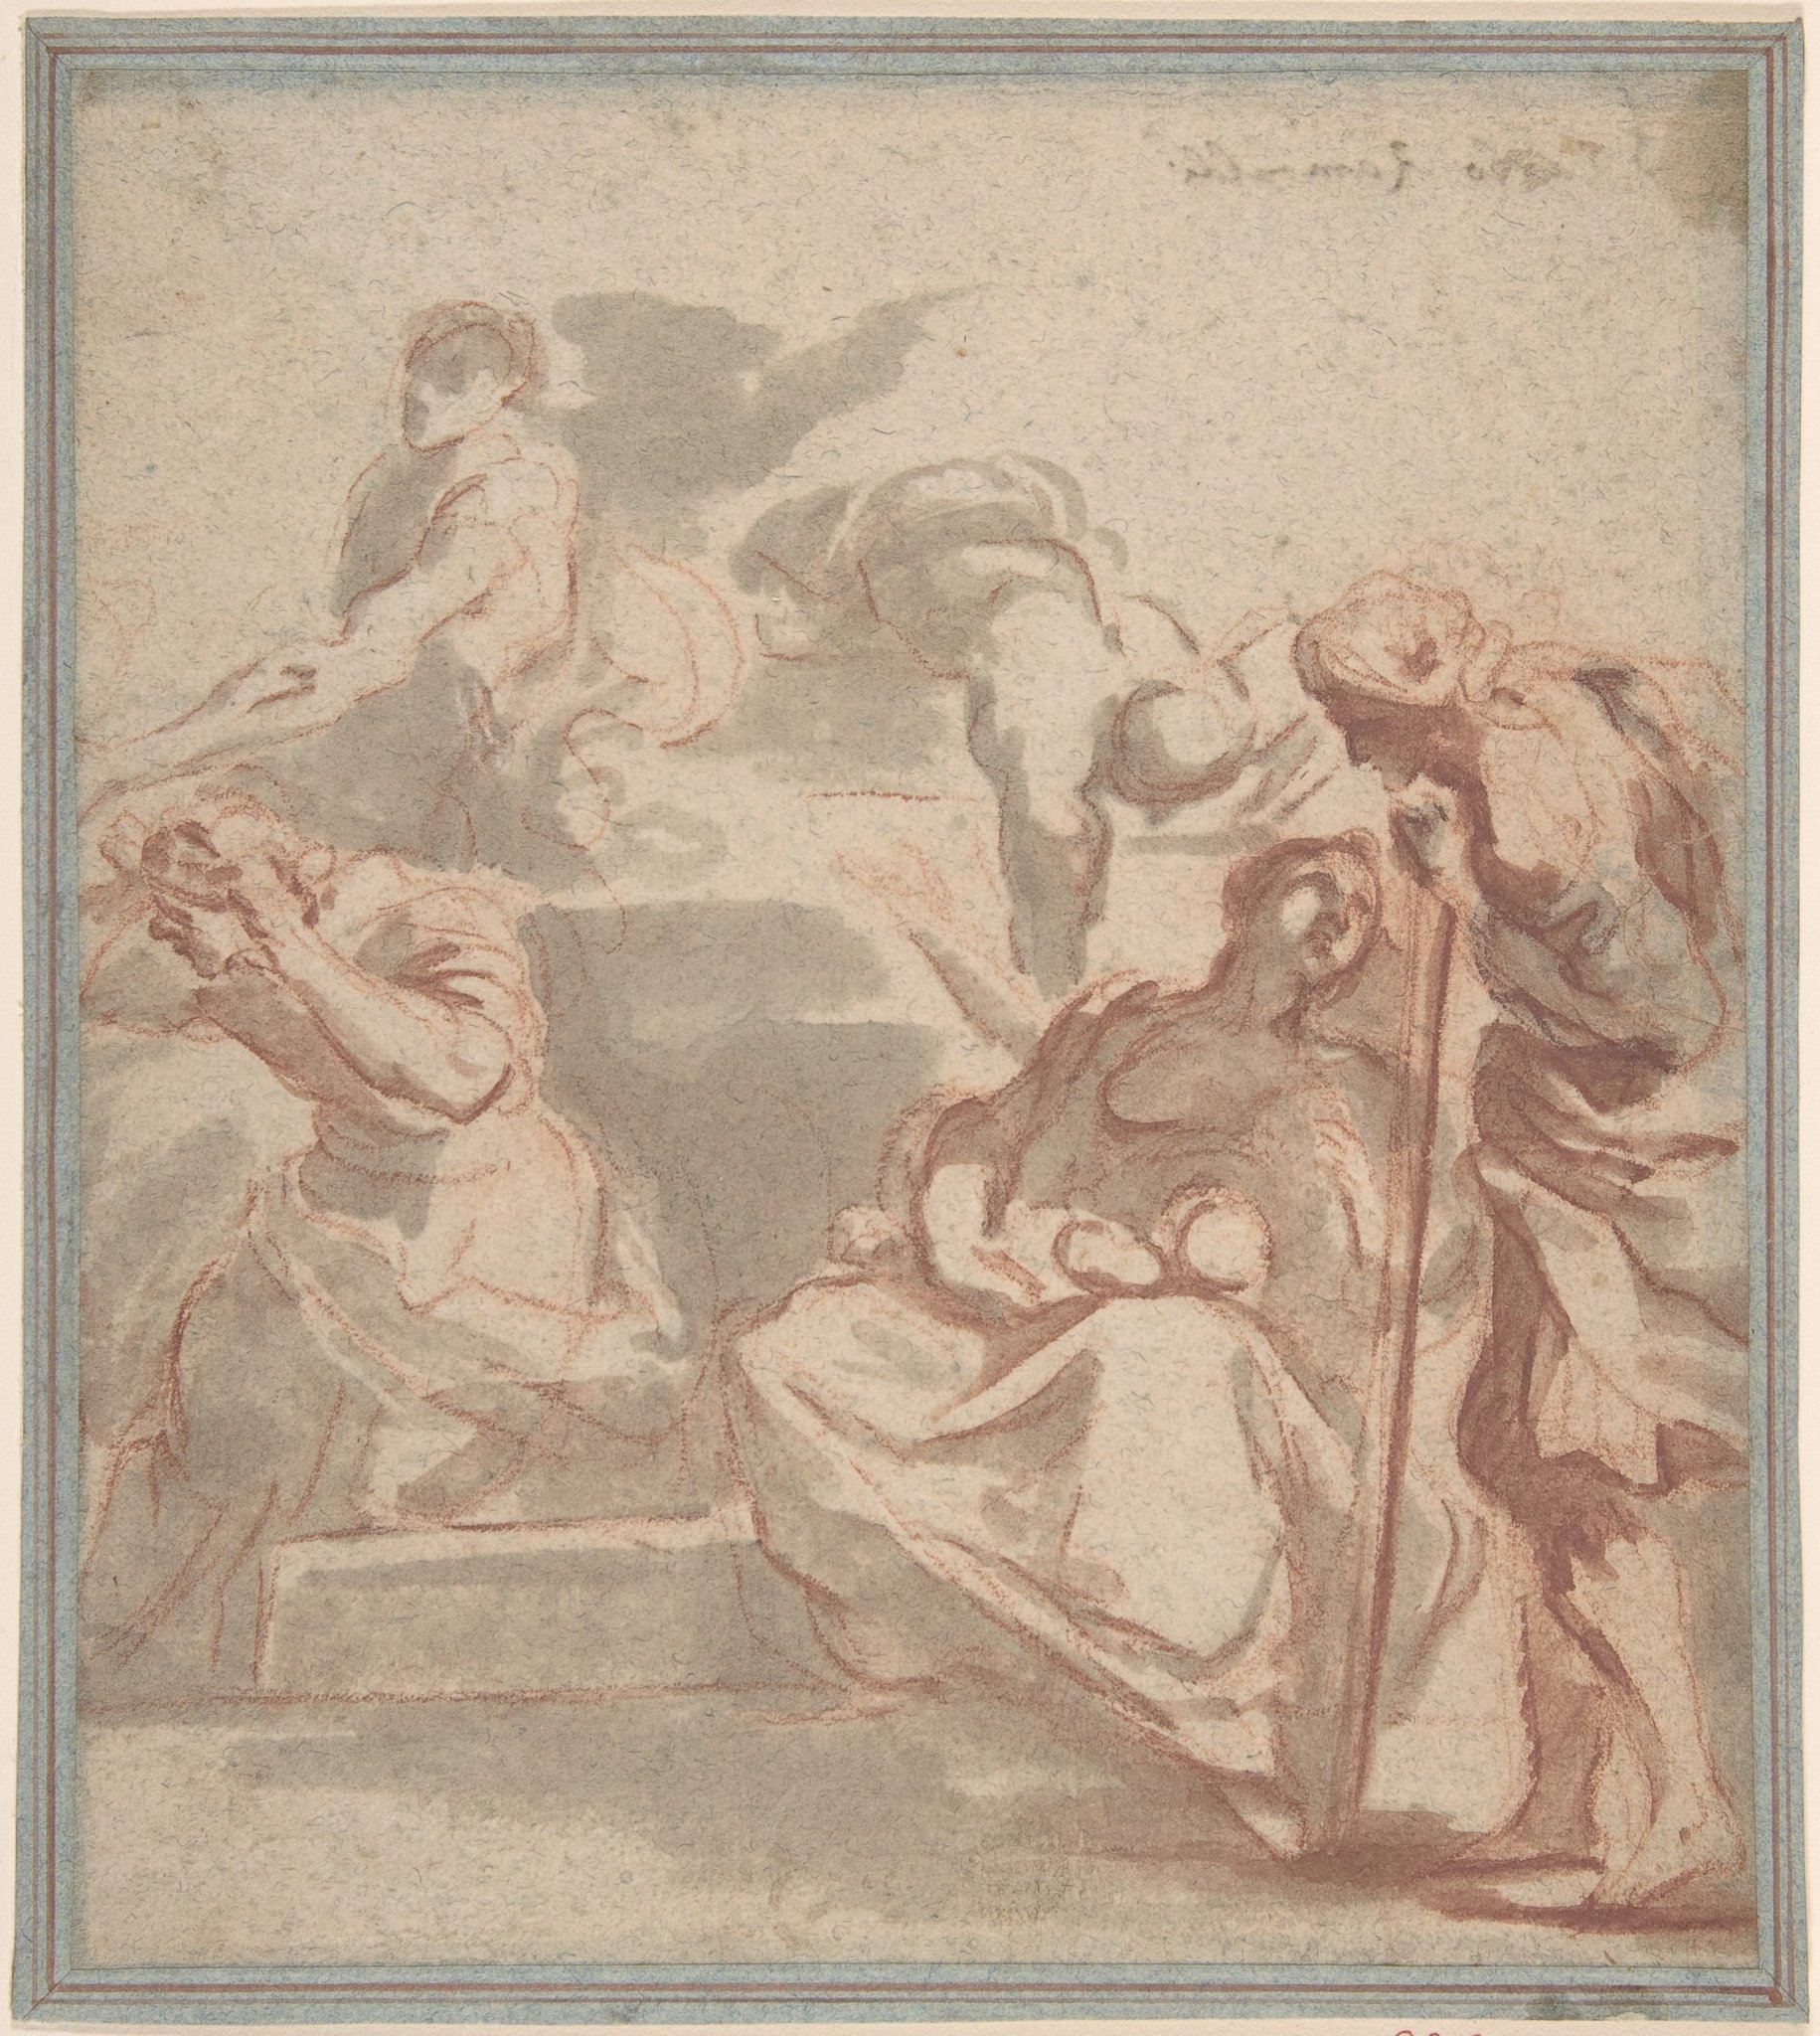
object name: drawing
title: Scene with Woman and Child, and Beggar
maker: anonymous, italian, roman-bolognese, 17th century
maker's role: artist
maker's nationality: italian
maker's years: 1600-1700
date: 1601-1700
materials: chalk, paper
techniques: brush, wash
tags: infants,men,women